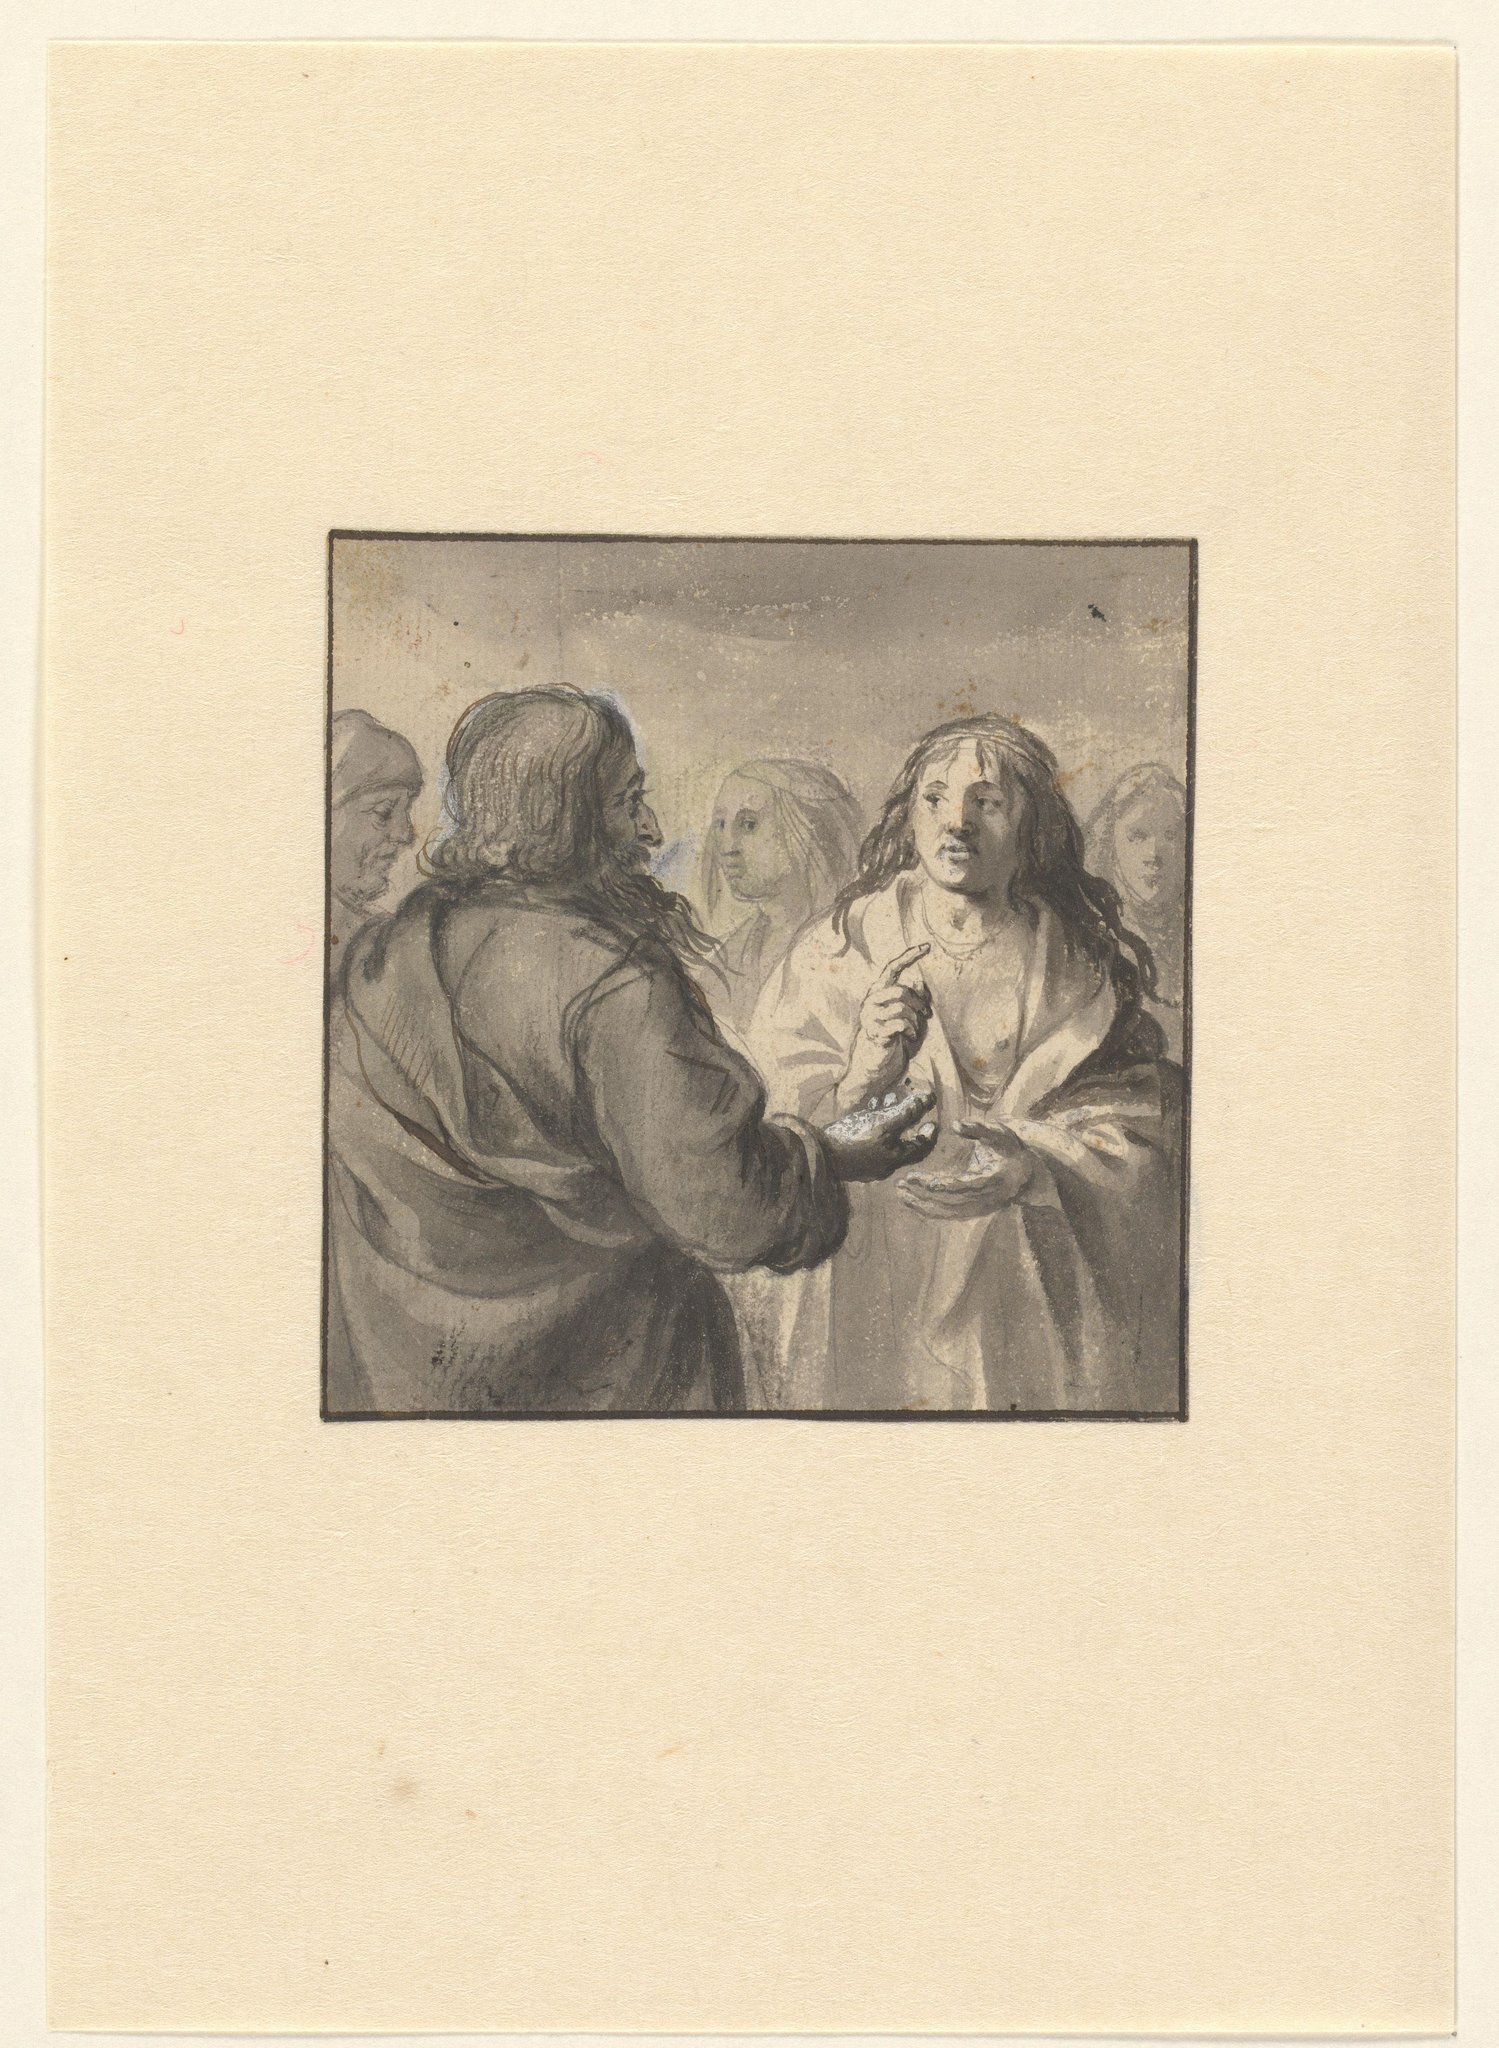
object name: drawing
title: Waarzegster in een groepje van vijf figuren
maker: jacob duck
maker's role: draughtsman, painter, print maker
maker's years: 1600-1667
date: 1610-1660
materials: paint, paper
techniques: brush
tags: fortune-teller ~ pleasure fair and circus